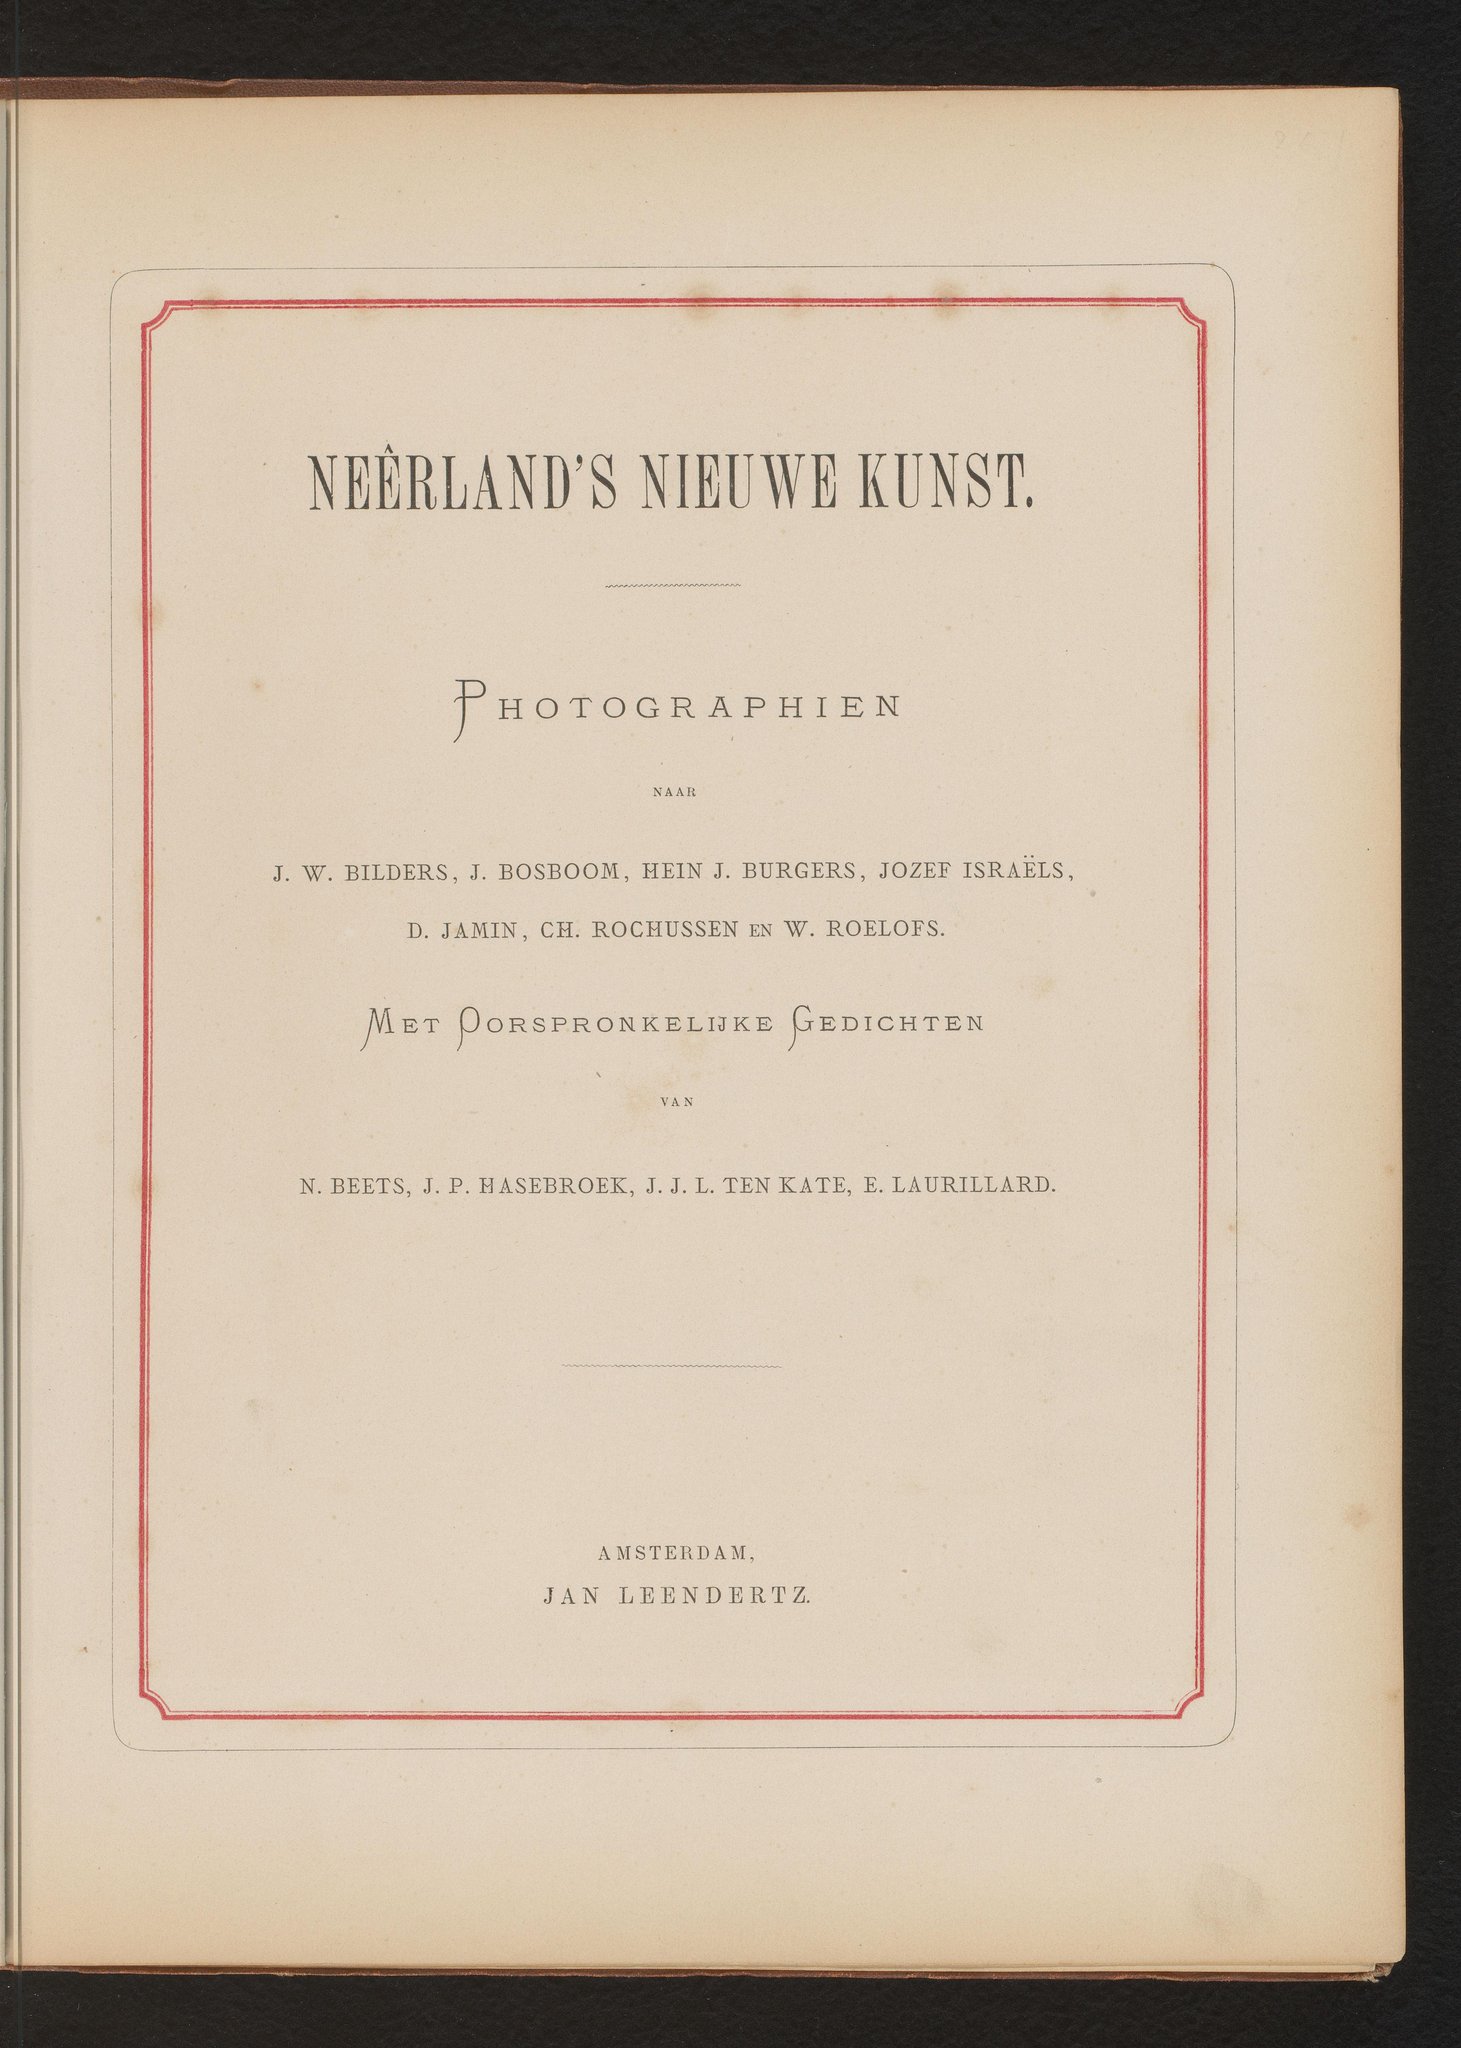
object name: book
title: Neêrland's nieuwe kunst : photographien naar J.W. Bilders, J. Bosboom ... en W. Roelofs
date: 1866-1871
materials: linen, paper, wood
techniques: albumen print, letterpress printing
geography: amsterdam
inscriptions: inscription: ‘f 12,50’, inscription: ‘A. BEUKHOF/ Boekbinders/ AMSTERDAM’